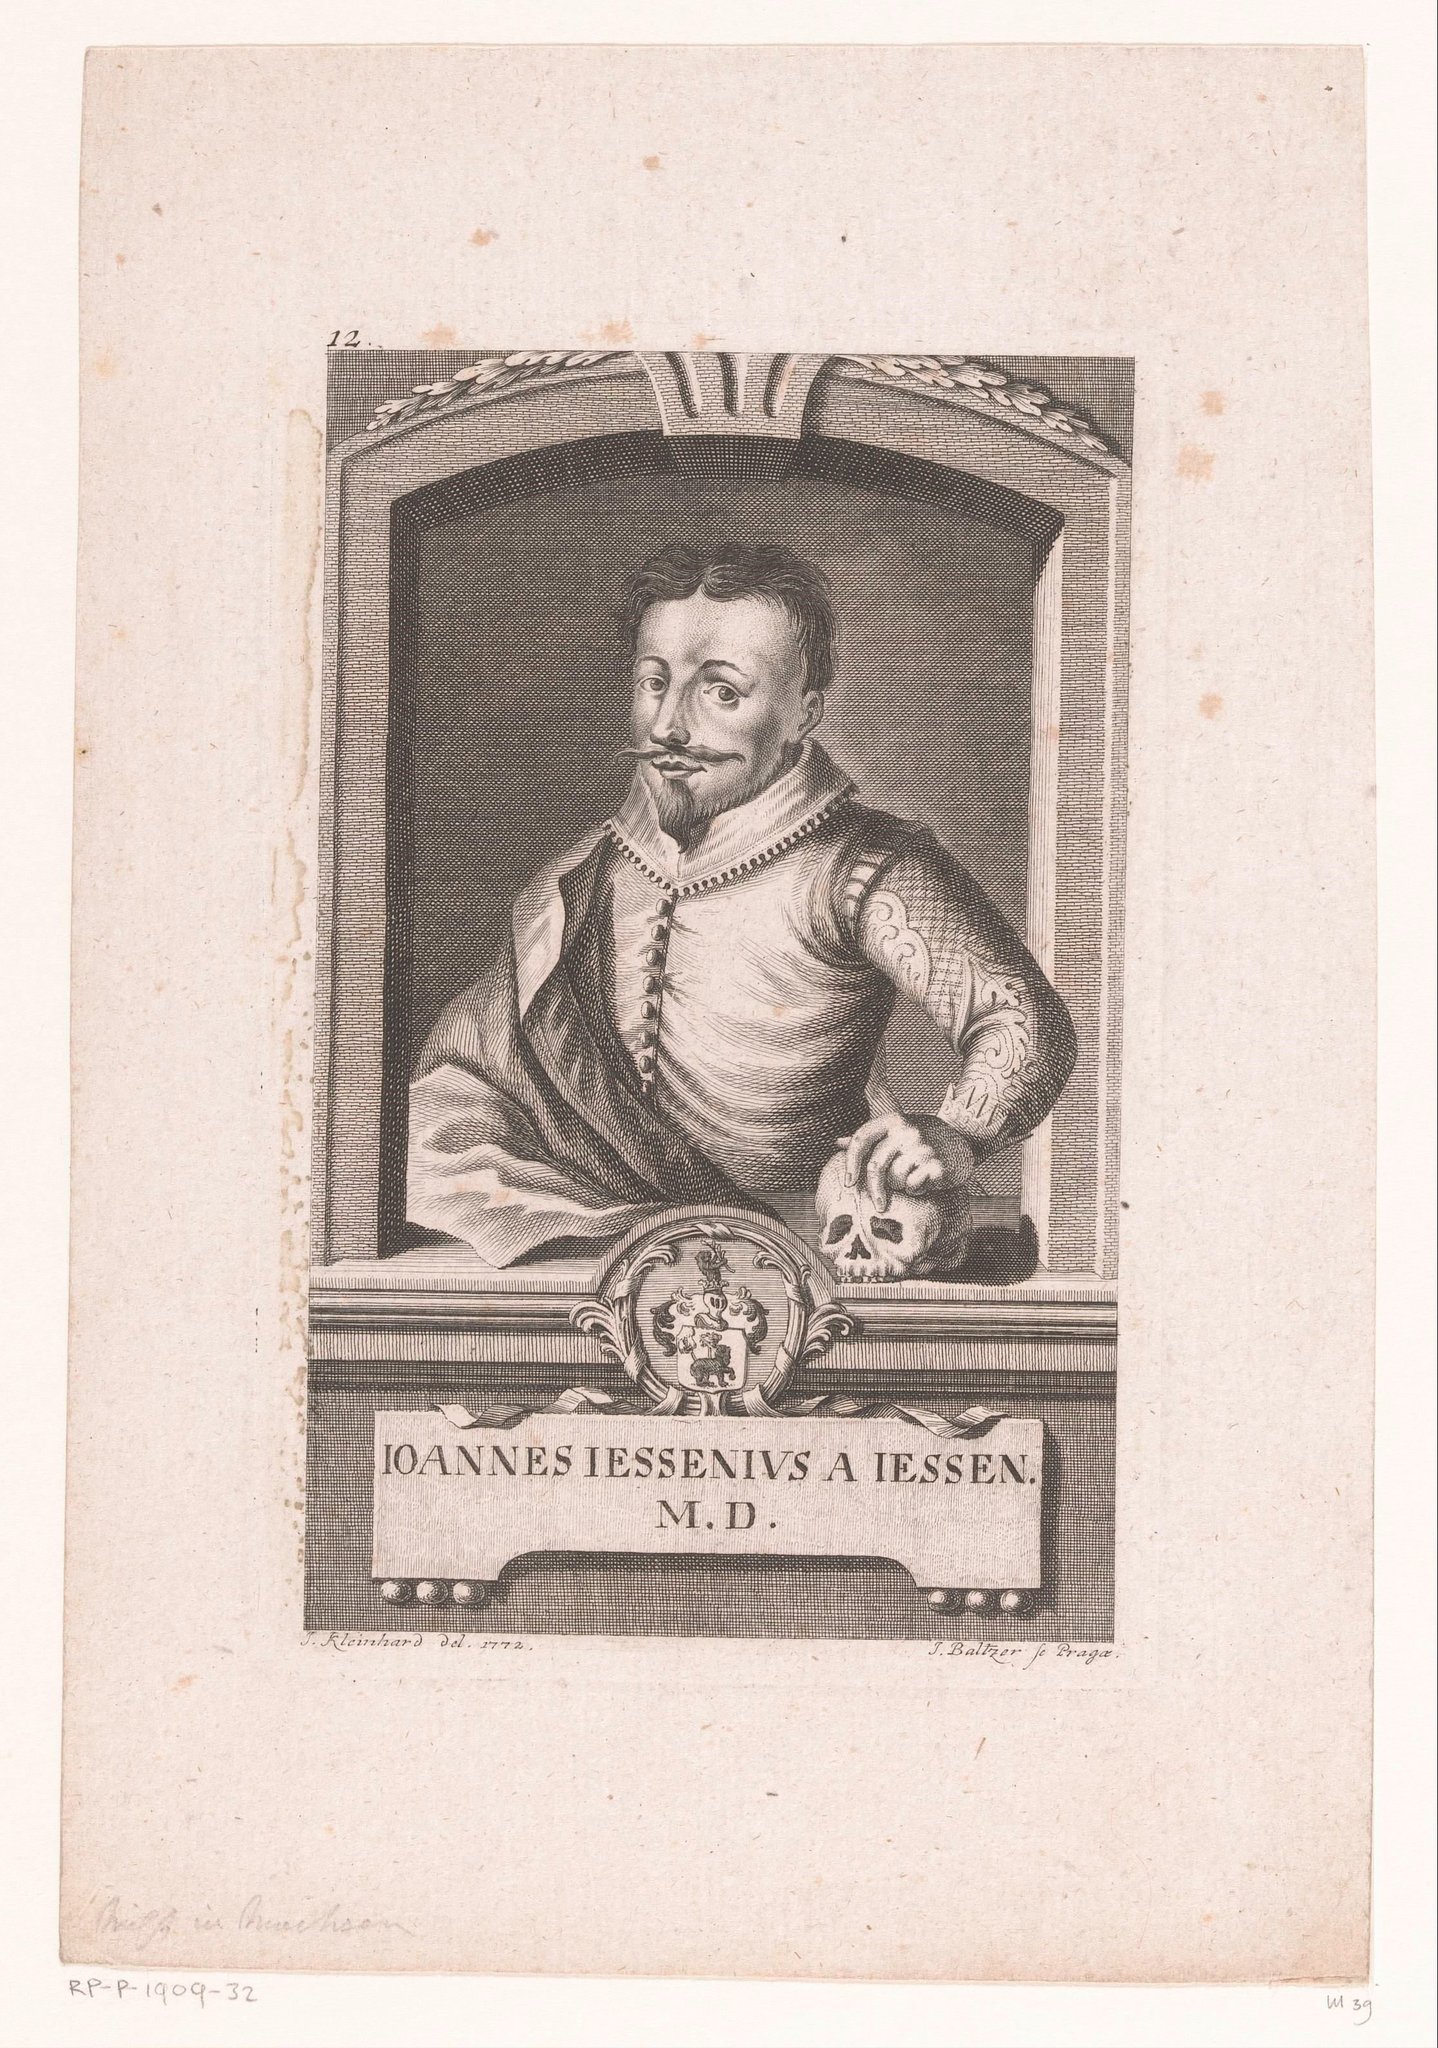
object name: print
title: Ioannes Iessenius a Iessen. M.D.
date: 1772-1799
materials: paper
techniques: engraving, etching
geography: prague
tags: politician, (human) skull, moustache, historical persons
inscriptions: collector's mark: Lugt 2228